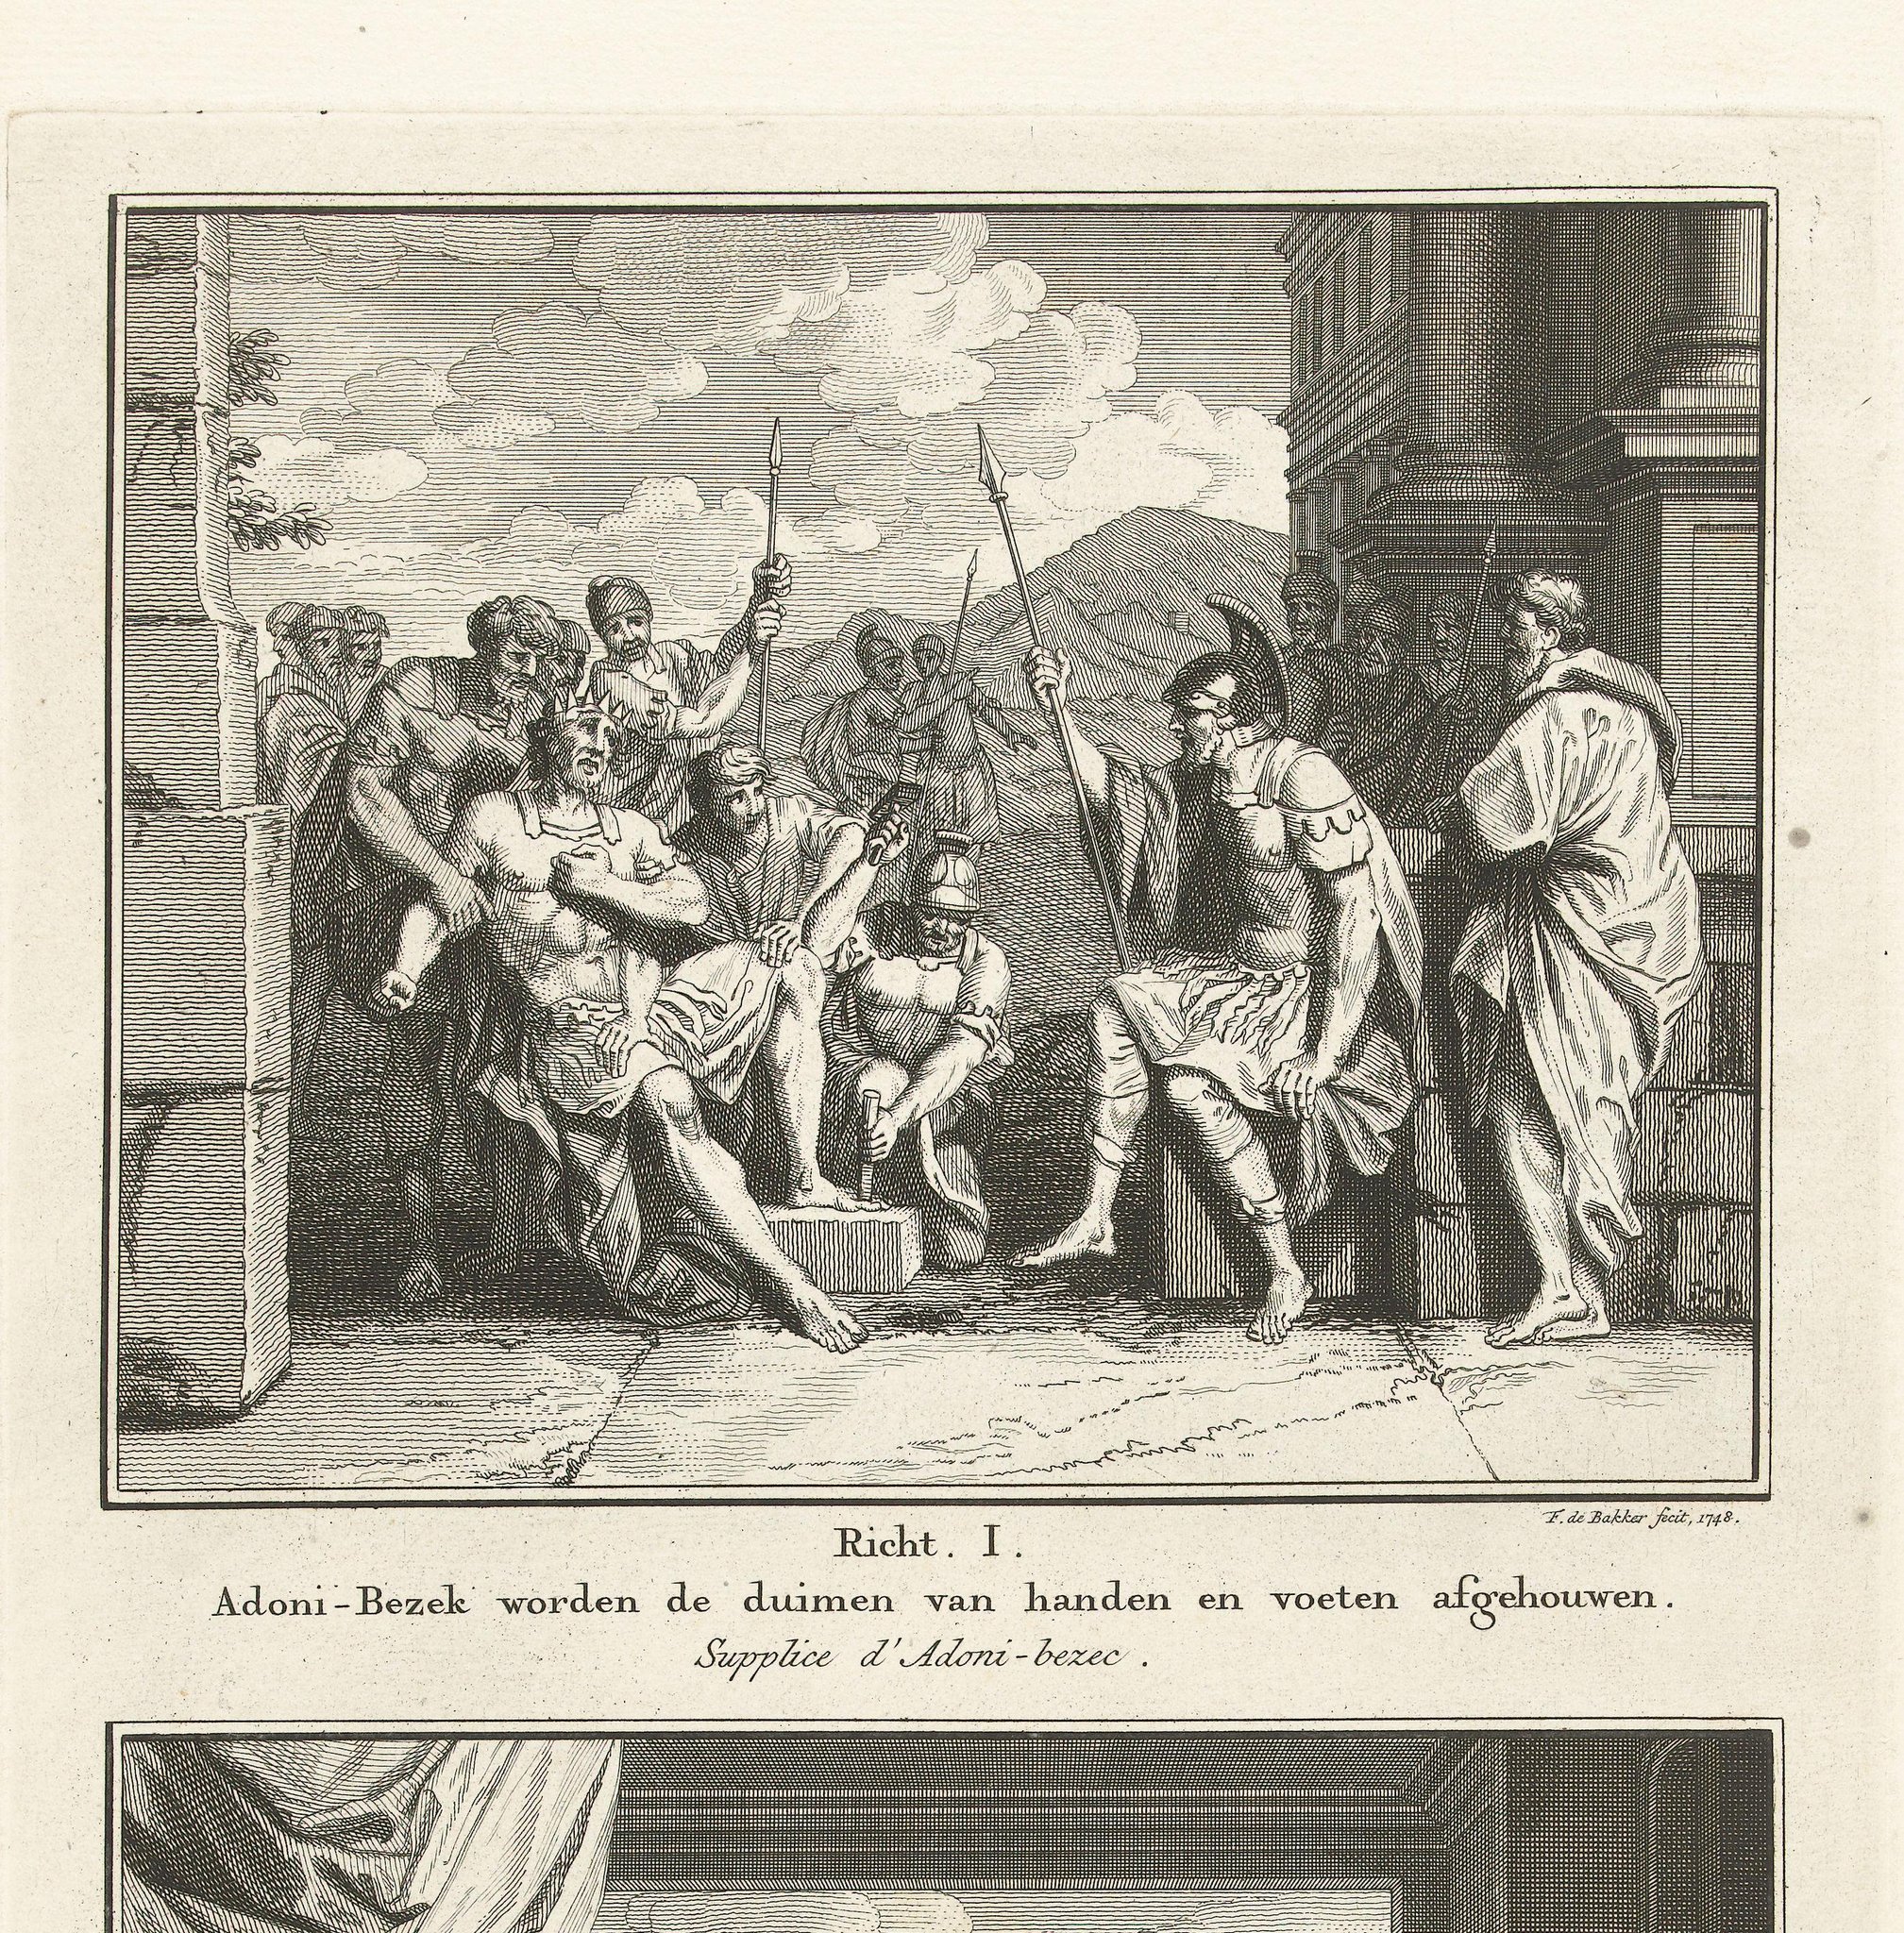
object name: print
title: Pijniging van Adonibezek; Eglon door Ehud gedood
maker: frans de bakker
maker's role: print maker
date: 1748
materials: paper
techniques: engraving, etching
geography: amsterdam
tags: adoni-bezek is caught; his thumbs and his great toes are cut off, eglon is found dead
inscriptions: collector's mark: Lugt 2233, collector's mark: Lugt 3937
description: Twee voorstellingen op een plaat. Boven: de Judeëers houwen Adonibezeks duimen en teennagels af. Onder: Koning Eglon ligt dood op de grond, een mes steekt in zijn buik. Twee soldaten snellen op hem af. Met onderschriften in het Nederlands en Frans.